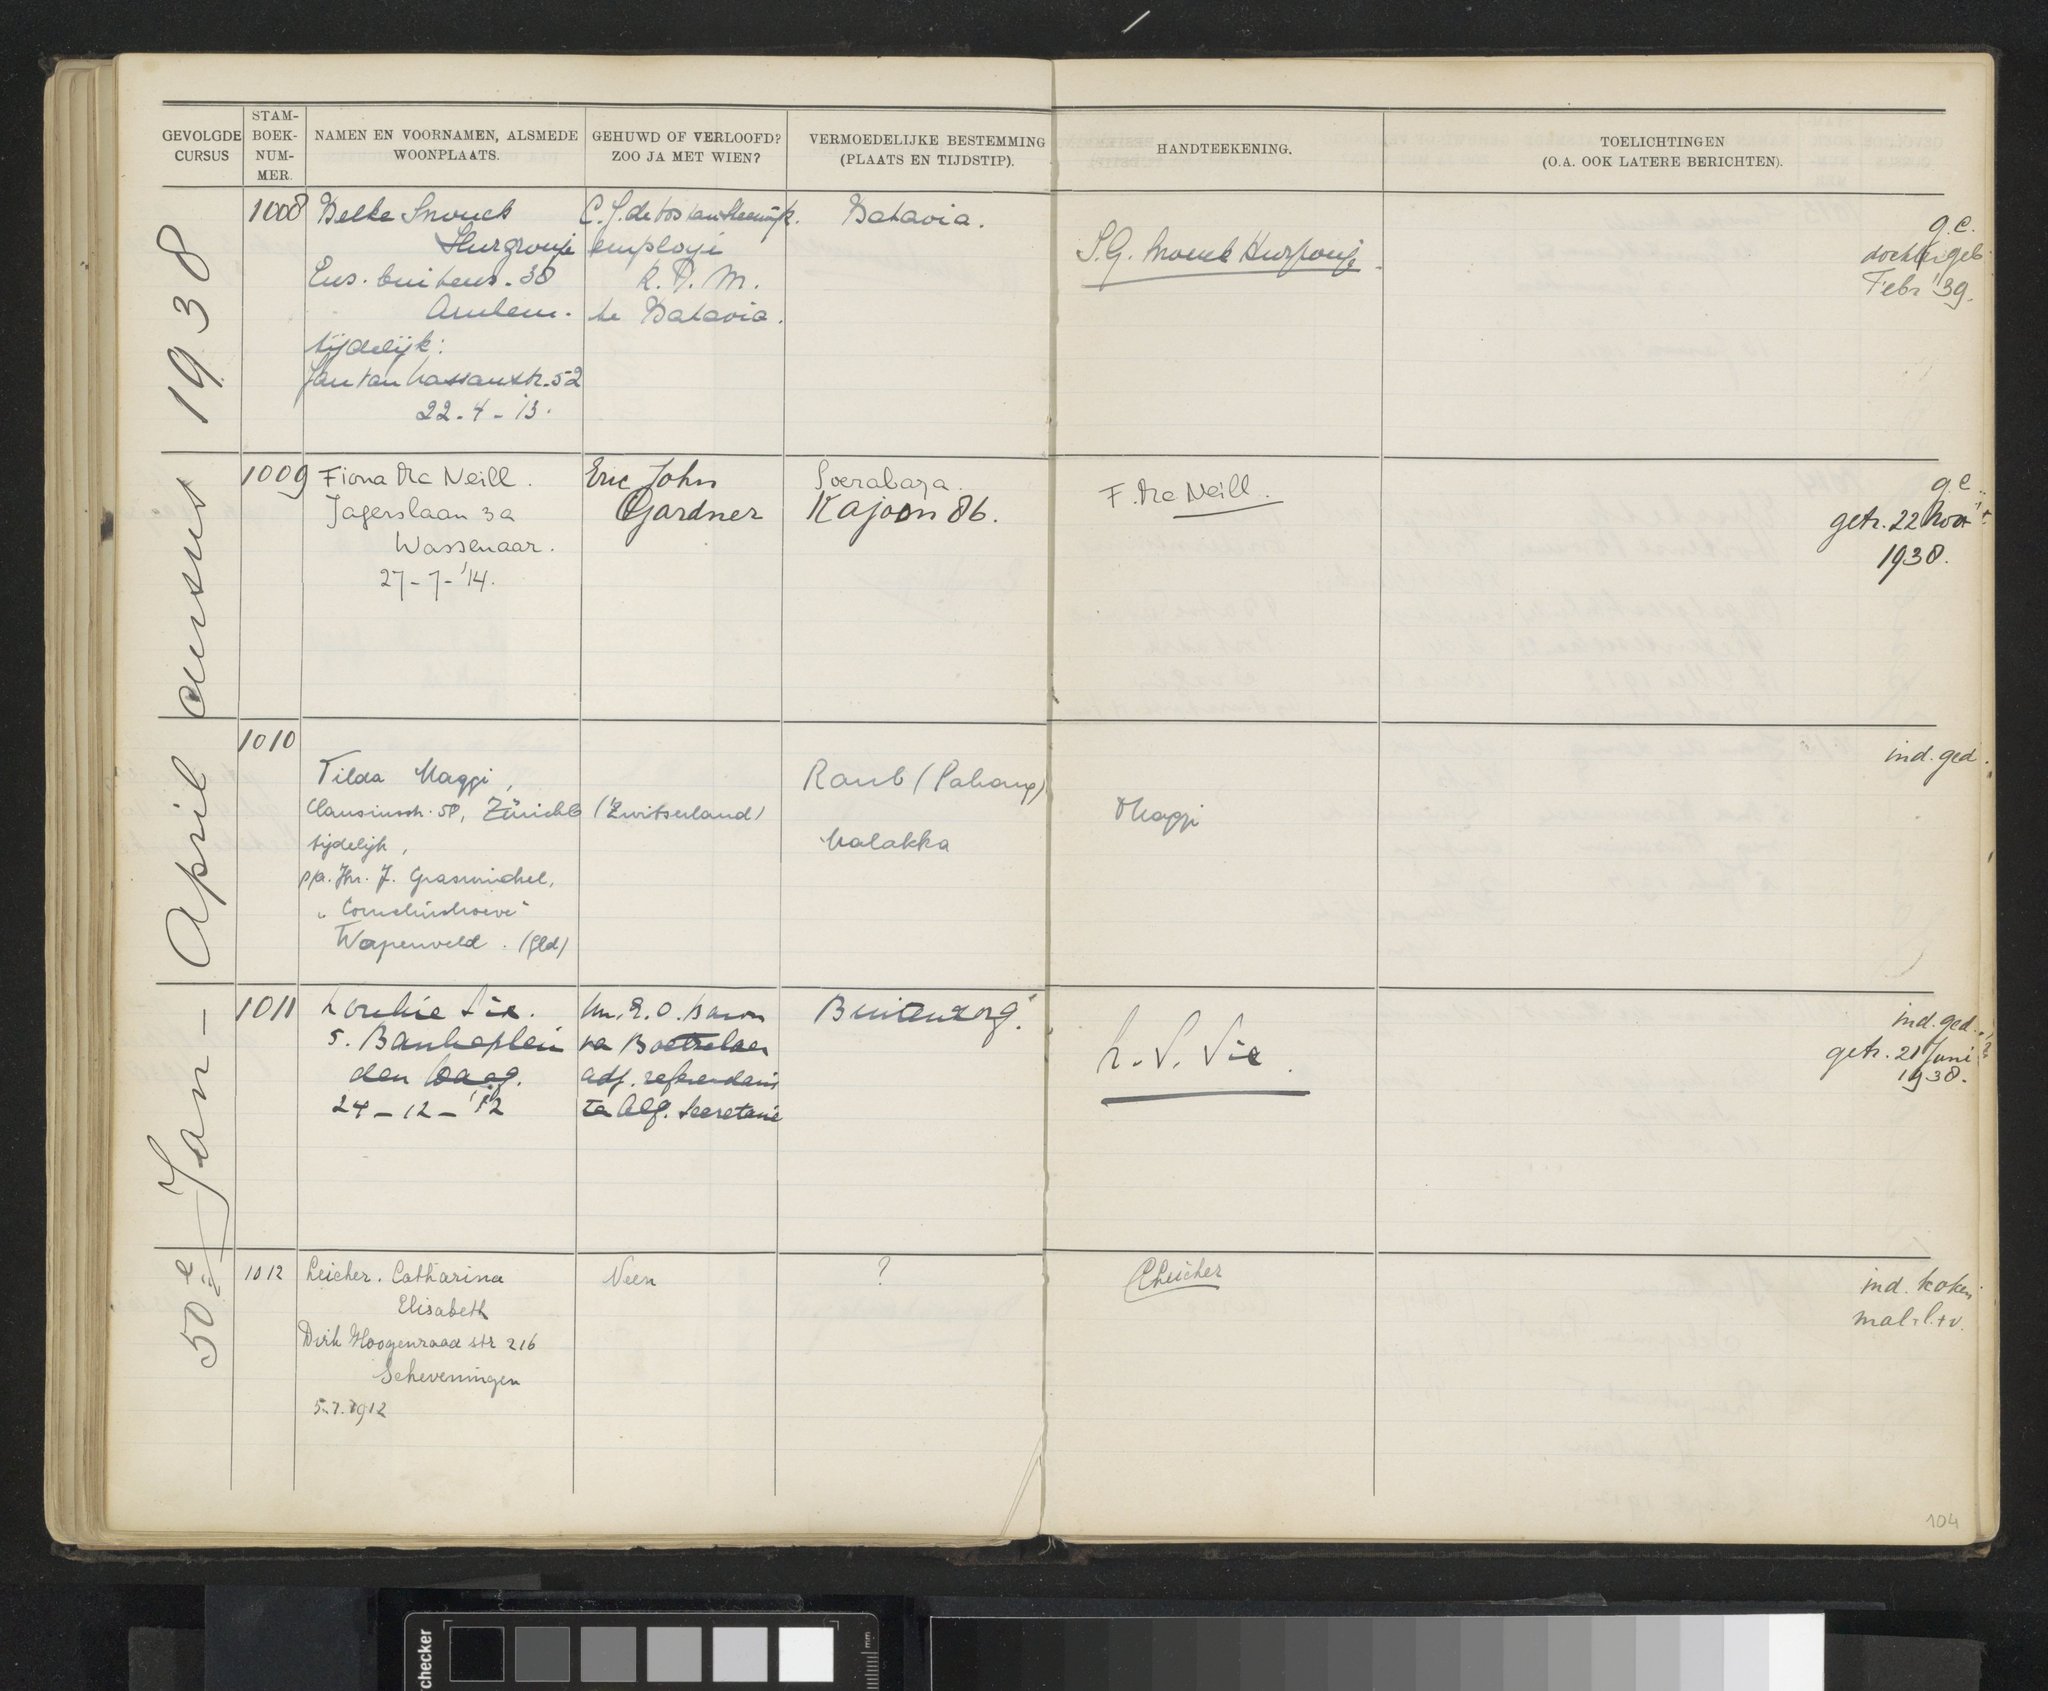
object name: album leaf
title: Blad 104 uit Stamboek van de leerlingen der Koloniale School voor Meisjes en Vrouwen te 's-Gravenhage deel II (1930-1949)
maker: Anonymous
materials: paper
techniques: printing, writing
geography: the hague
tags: further education (+ pupil), further education, the hague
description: Twee pagina's met gegevens van de deelnemers aan de 50e driemaandelijkse cursus van januari tot april 1938, stamboeknummers 1008 tot en met 1012. Onderdeel van Stamboek van de leerlingen der Koloniale School voor Meisjes en Vrouwen te 's-Gravenhage deel II (1930-1949).